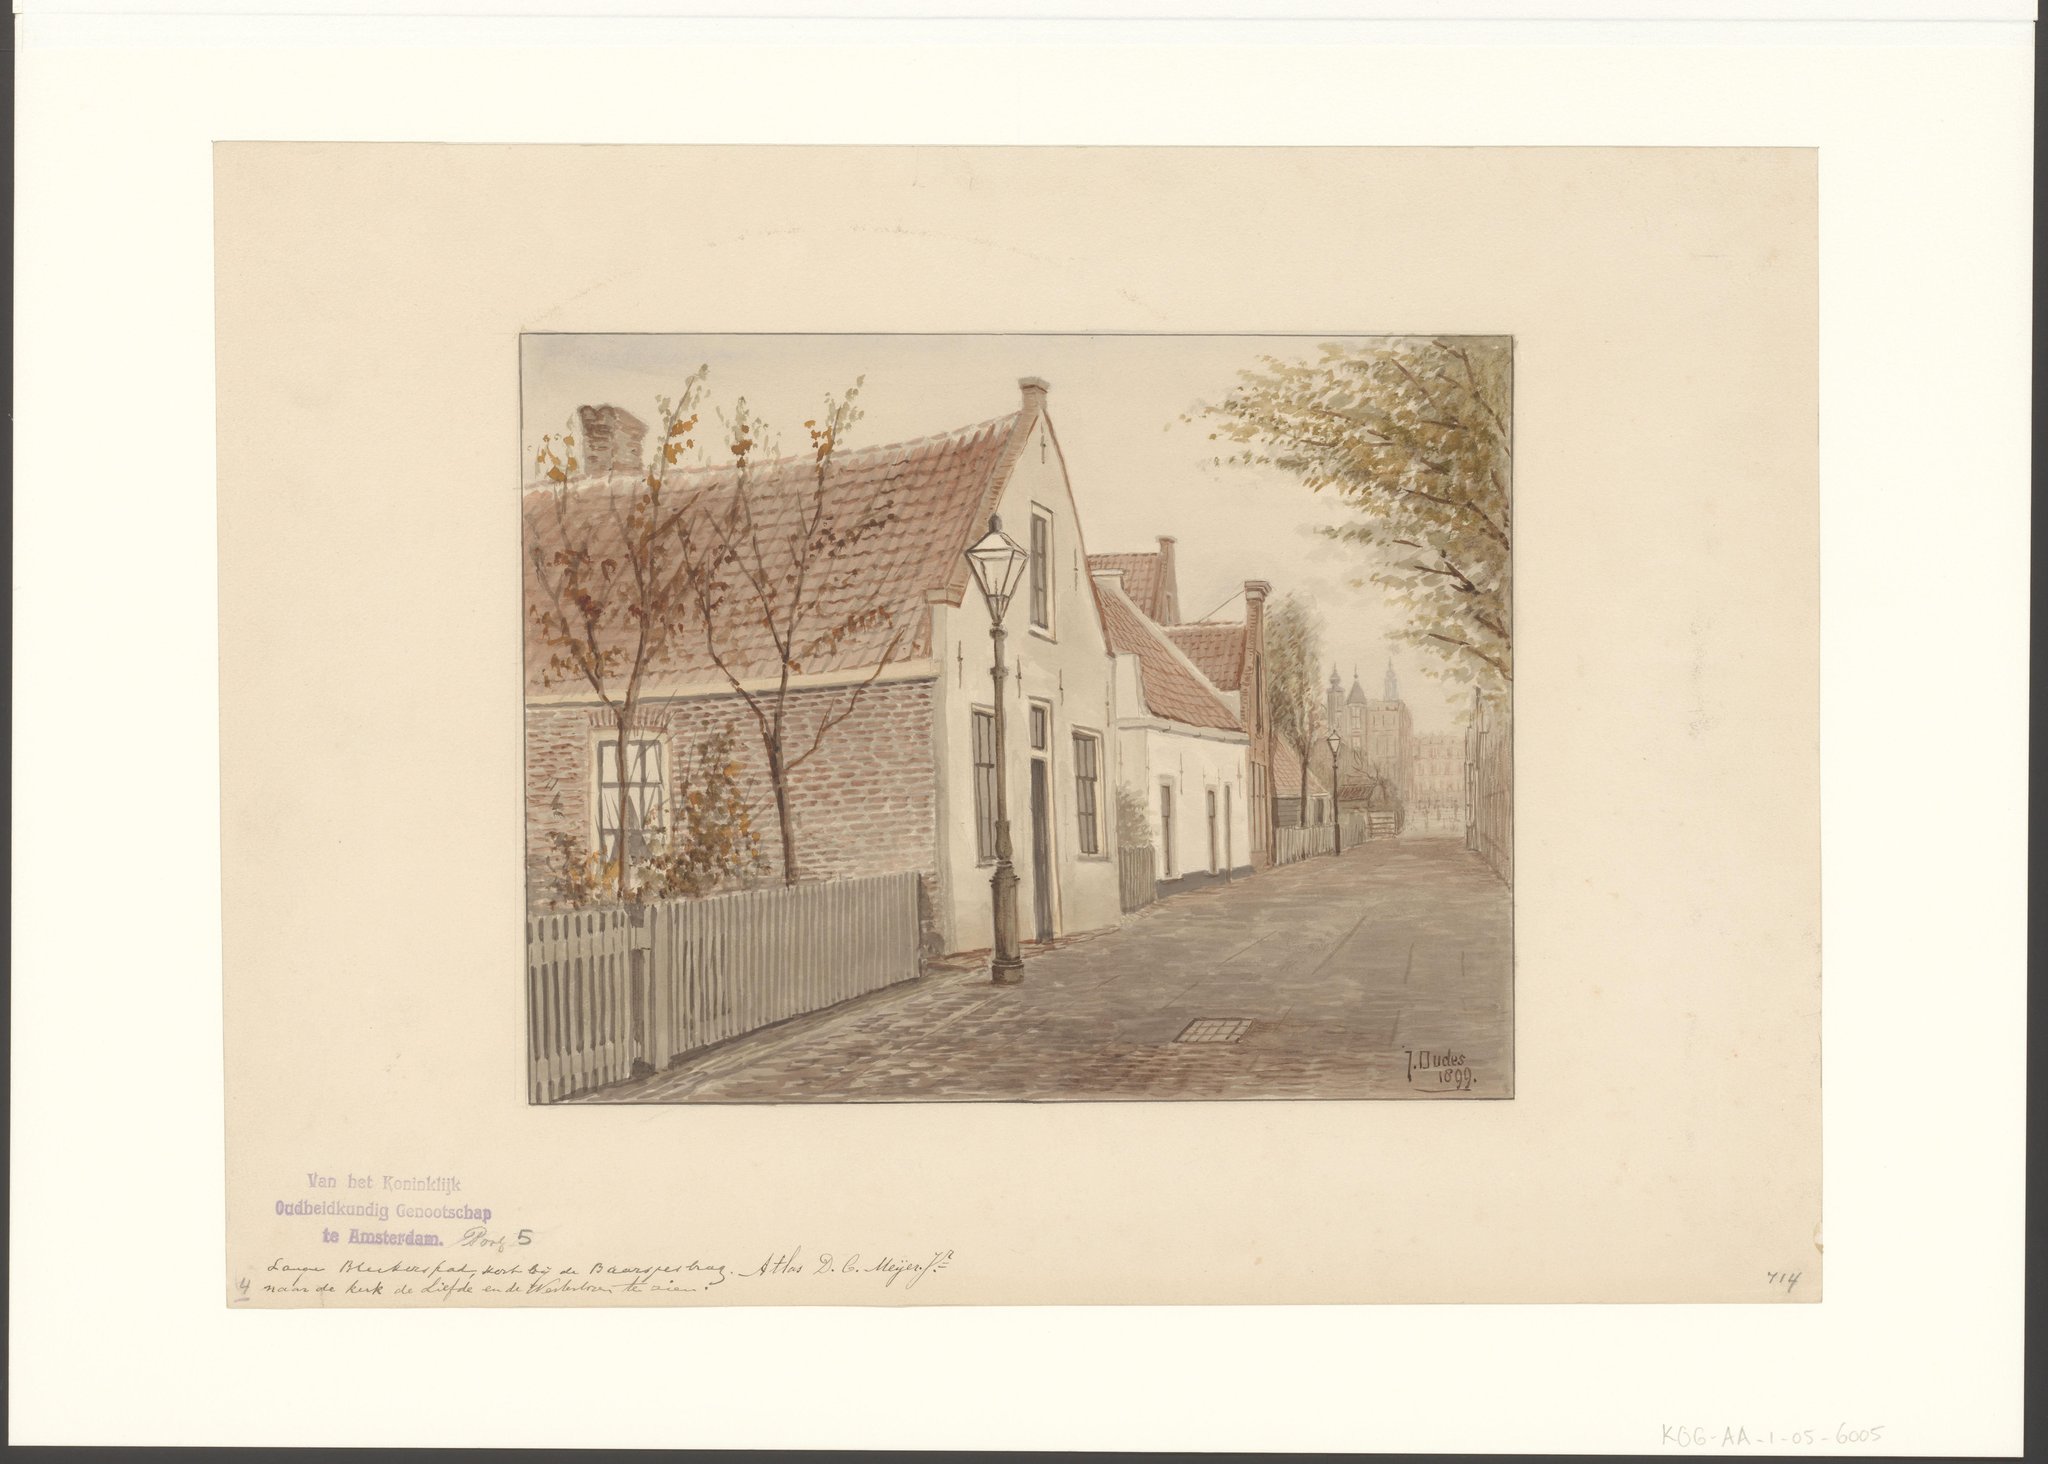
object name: drawing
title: Gezicht op het Lange Blekerspad, gezien naar de kerk De Liefde en de Westertoren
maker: jacob oudes (sr.)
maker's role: draughtsman, painter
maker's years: 1858-1921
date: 1899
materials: ink, paper, pencil, watercolor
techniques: brush, pen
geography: amsterdam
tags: city-view in general; 'veduta', the usual house or row of houses, street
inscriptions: stamp: ‘Van het Koninklijk / Oudheidkundig Genootschap / te Amsterdam. Port. 5’, inscription: ‘Lange Bleekerspad naar (...) de R[...] brug’, signature and date: ‘J. Oudes / 1899.’, inscription: ‘Lange Bleekerspad, kerk (...) D. C. Meijer. Jr.’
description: Onderwerpsrubriek binnen de Atlas Amsterdam: Begijnensloot (Gedempte), Bagijnhofsteeg, Beulingsloot, Bickersgracht en –plein, Bickersstraat (Groote), Bilderdijkskade en -straat, Binnenkant, Blauwburgwal, Boomdwarsstraat, Brouwersgracht, Bleekersspad (Lange), Bleekerssloot, Bloemgracht, Boerenwetering, Boltensgrachtje, Boomssloot (Recht), Badhuisweg.